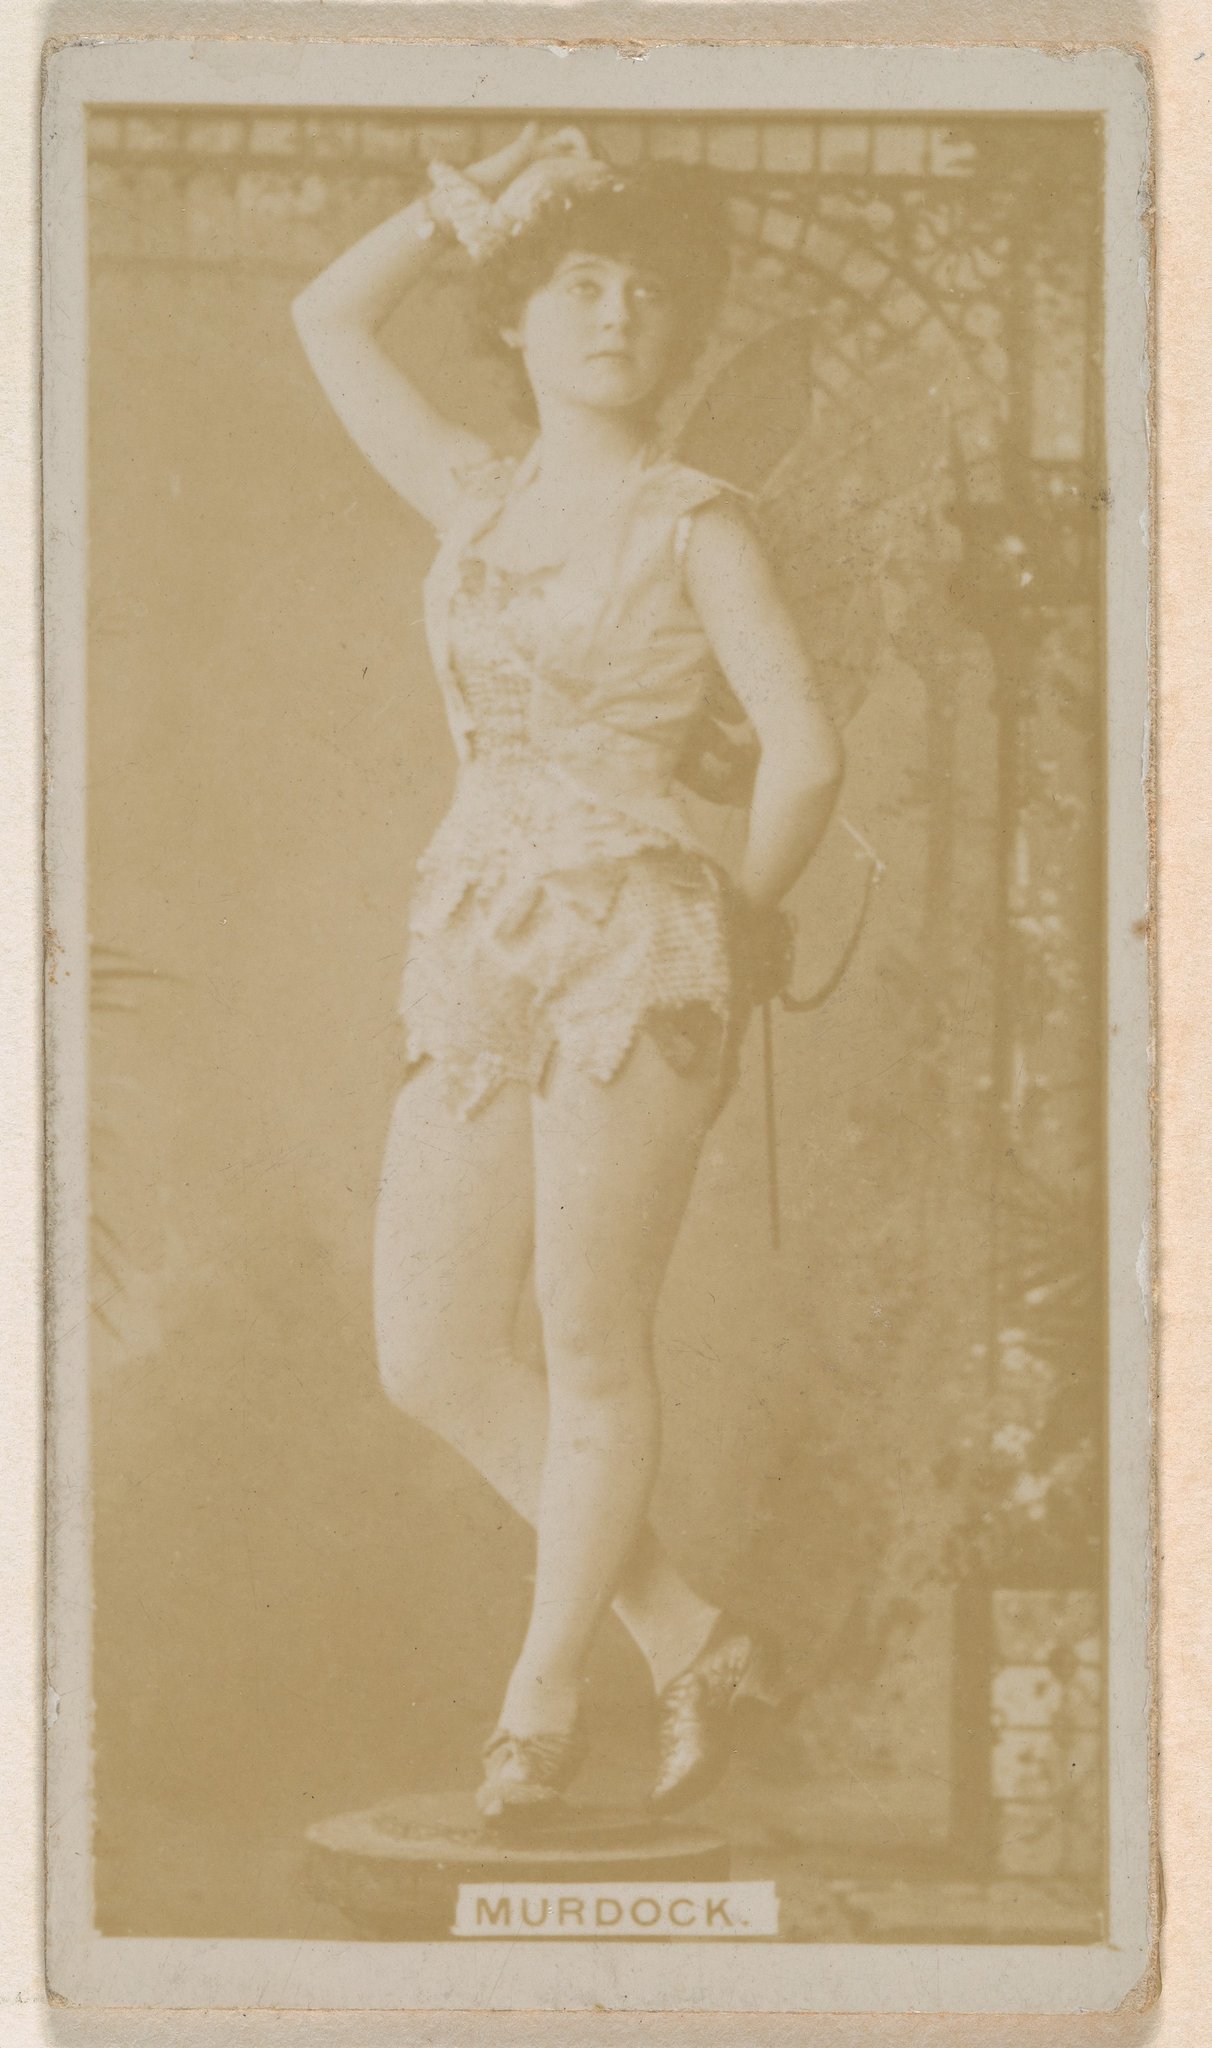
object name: photograph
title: Daisy Murdoch, from the Actresses series (N245) issued by Kinney Brothers to promote Sweet Caporal Cigarettes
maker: kinney brothers tobacco company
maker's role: publisher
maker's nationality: american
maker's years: 1869-2011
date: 1890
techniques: albumen silver print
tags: portraits,women,actresses